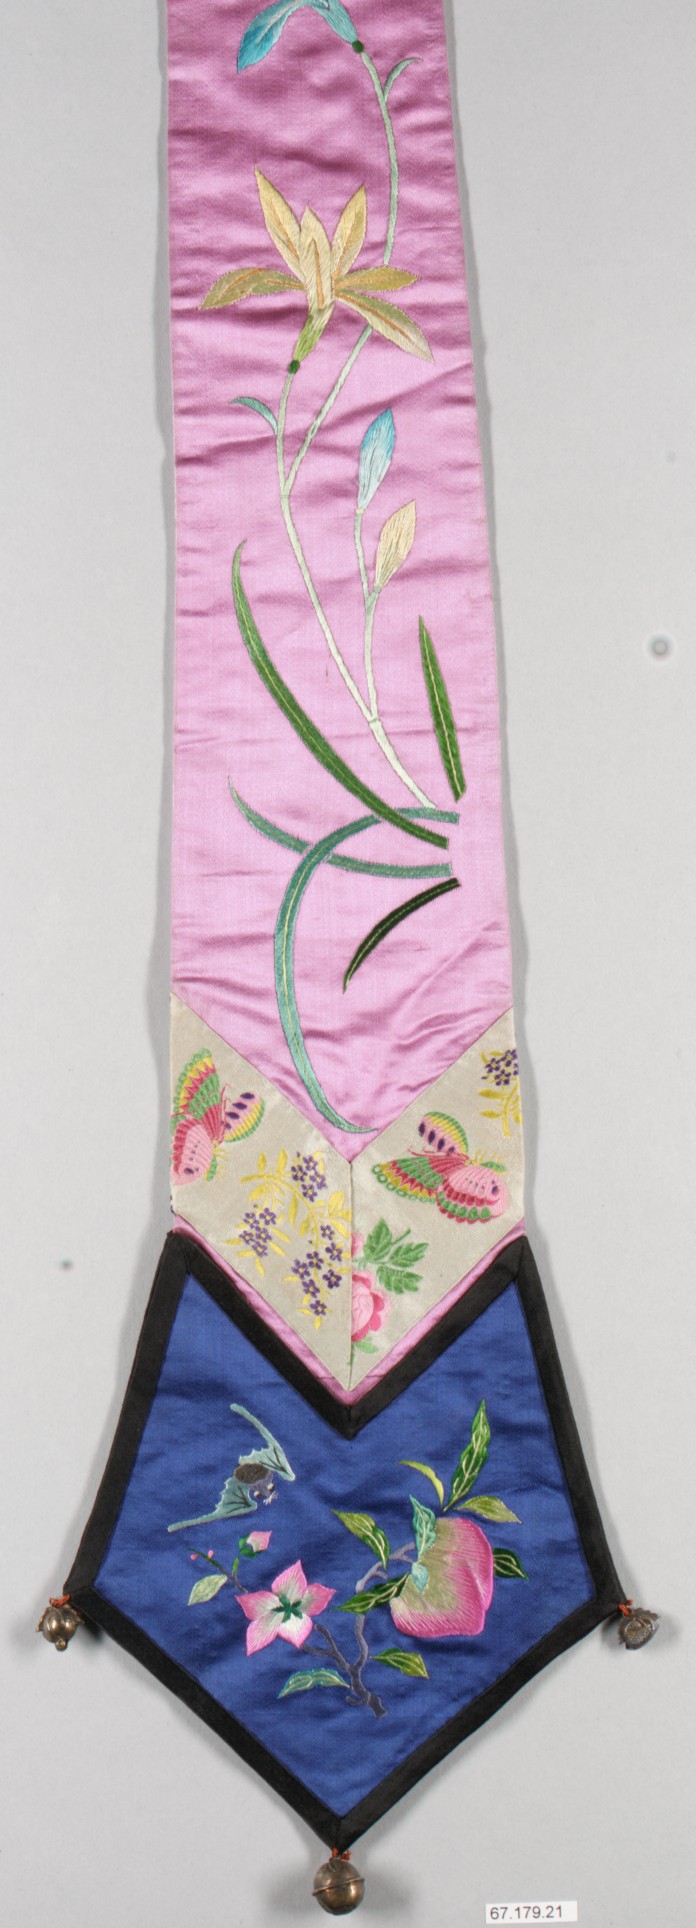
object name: streamer from dancer's costume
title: Streamers From Dancer's Costume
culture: chinese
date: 1801-1900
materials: bronze, silk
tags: flowers